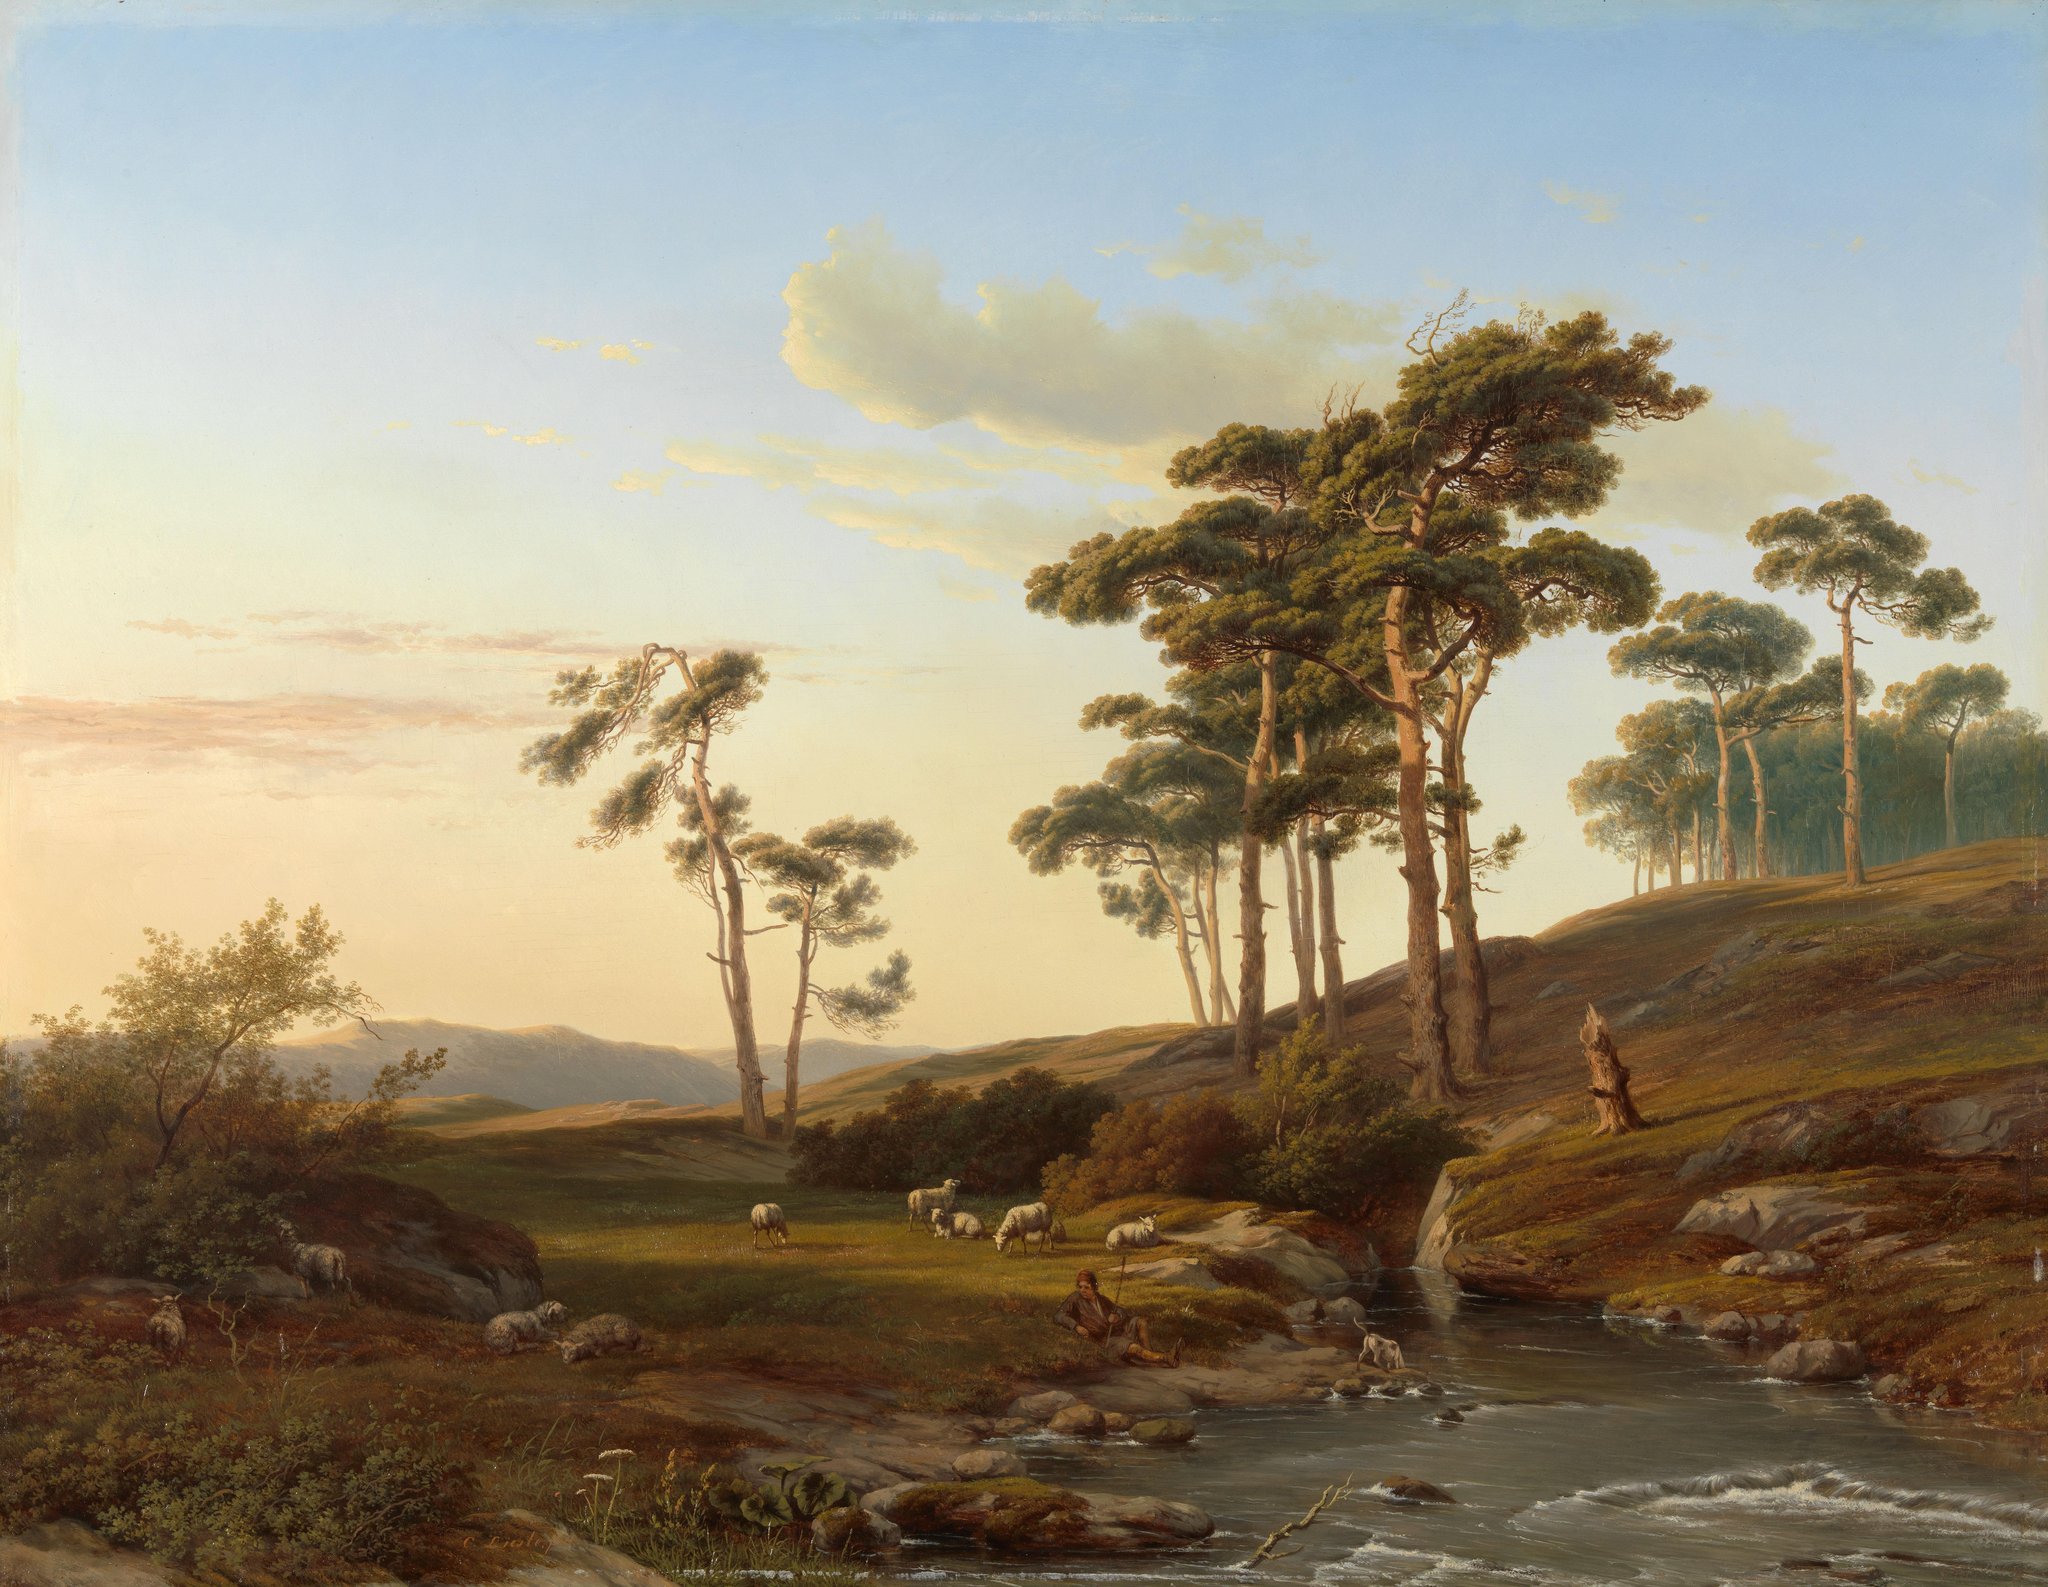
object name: painting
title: Avondstemming met herder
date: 1855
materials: wood, oil, paint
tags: sunset, pastorals, arcadian scenes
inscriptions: signature: ‘C. Lieste fecit’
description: In een heuvelachtig landschap bevindt zich op de voorgrond een herder met schapen bij een beek. Tegen de blauw-roze vrijwel wolkenloze avondlucht tekenen scherp enkele parasoldennen af.